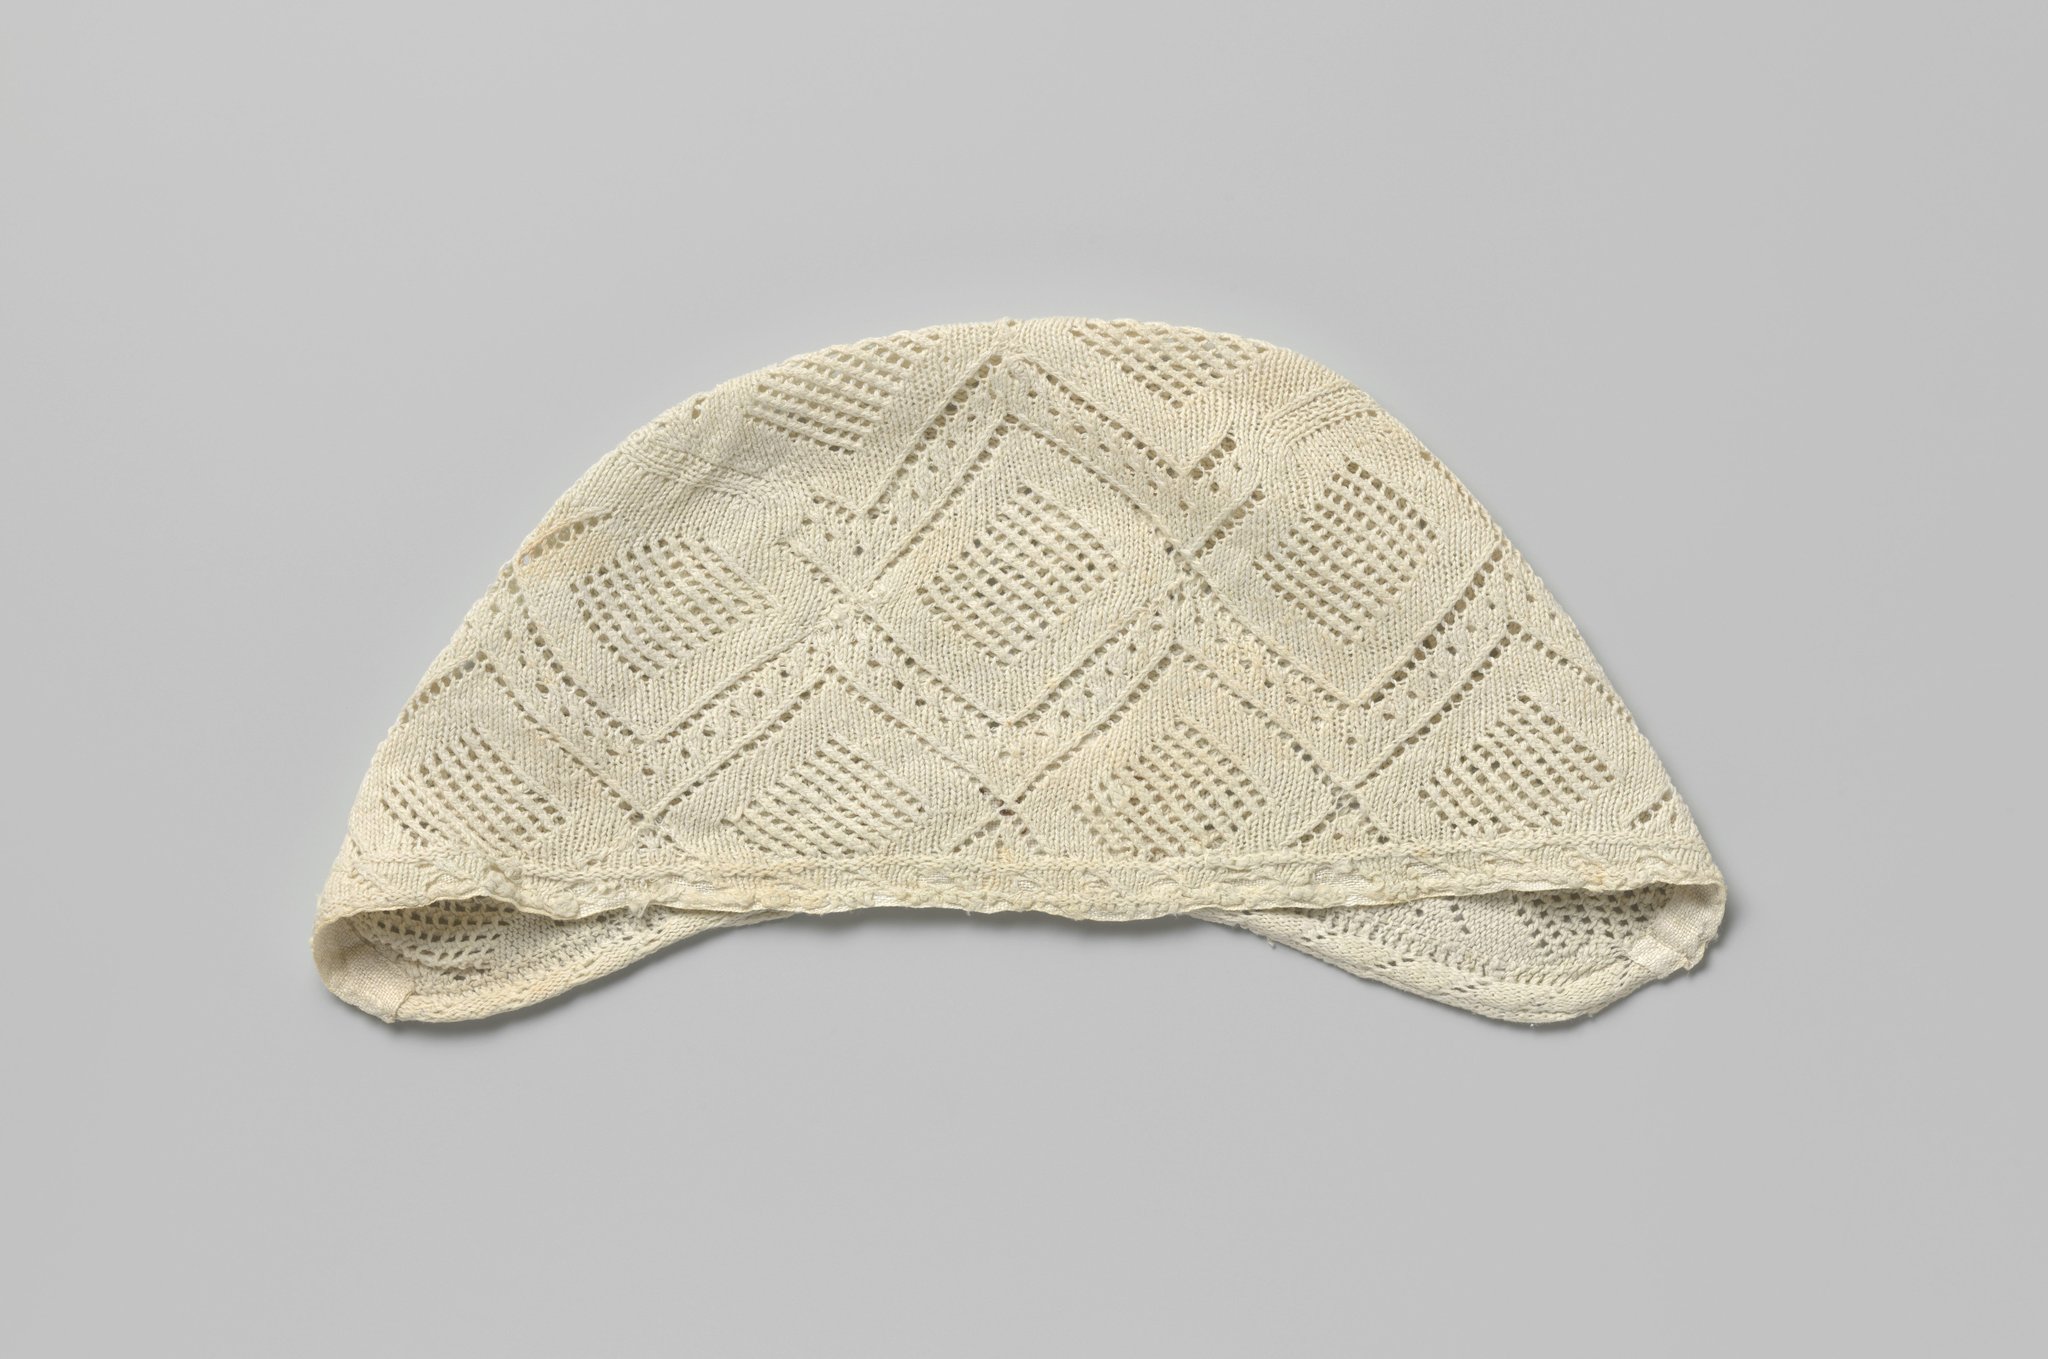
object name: womenswear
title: Gebreide muts van witte katoen met zigzagranden en ruitvormen met rasterwerk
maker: Anonymous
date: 1800-1900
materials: cotton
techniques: knitting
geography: europe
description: Gebreide muts van witte katoen met zigzagranden en ruitvormen met rasterwerk.